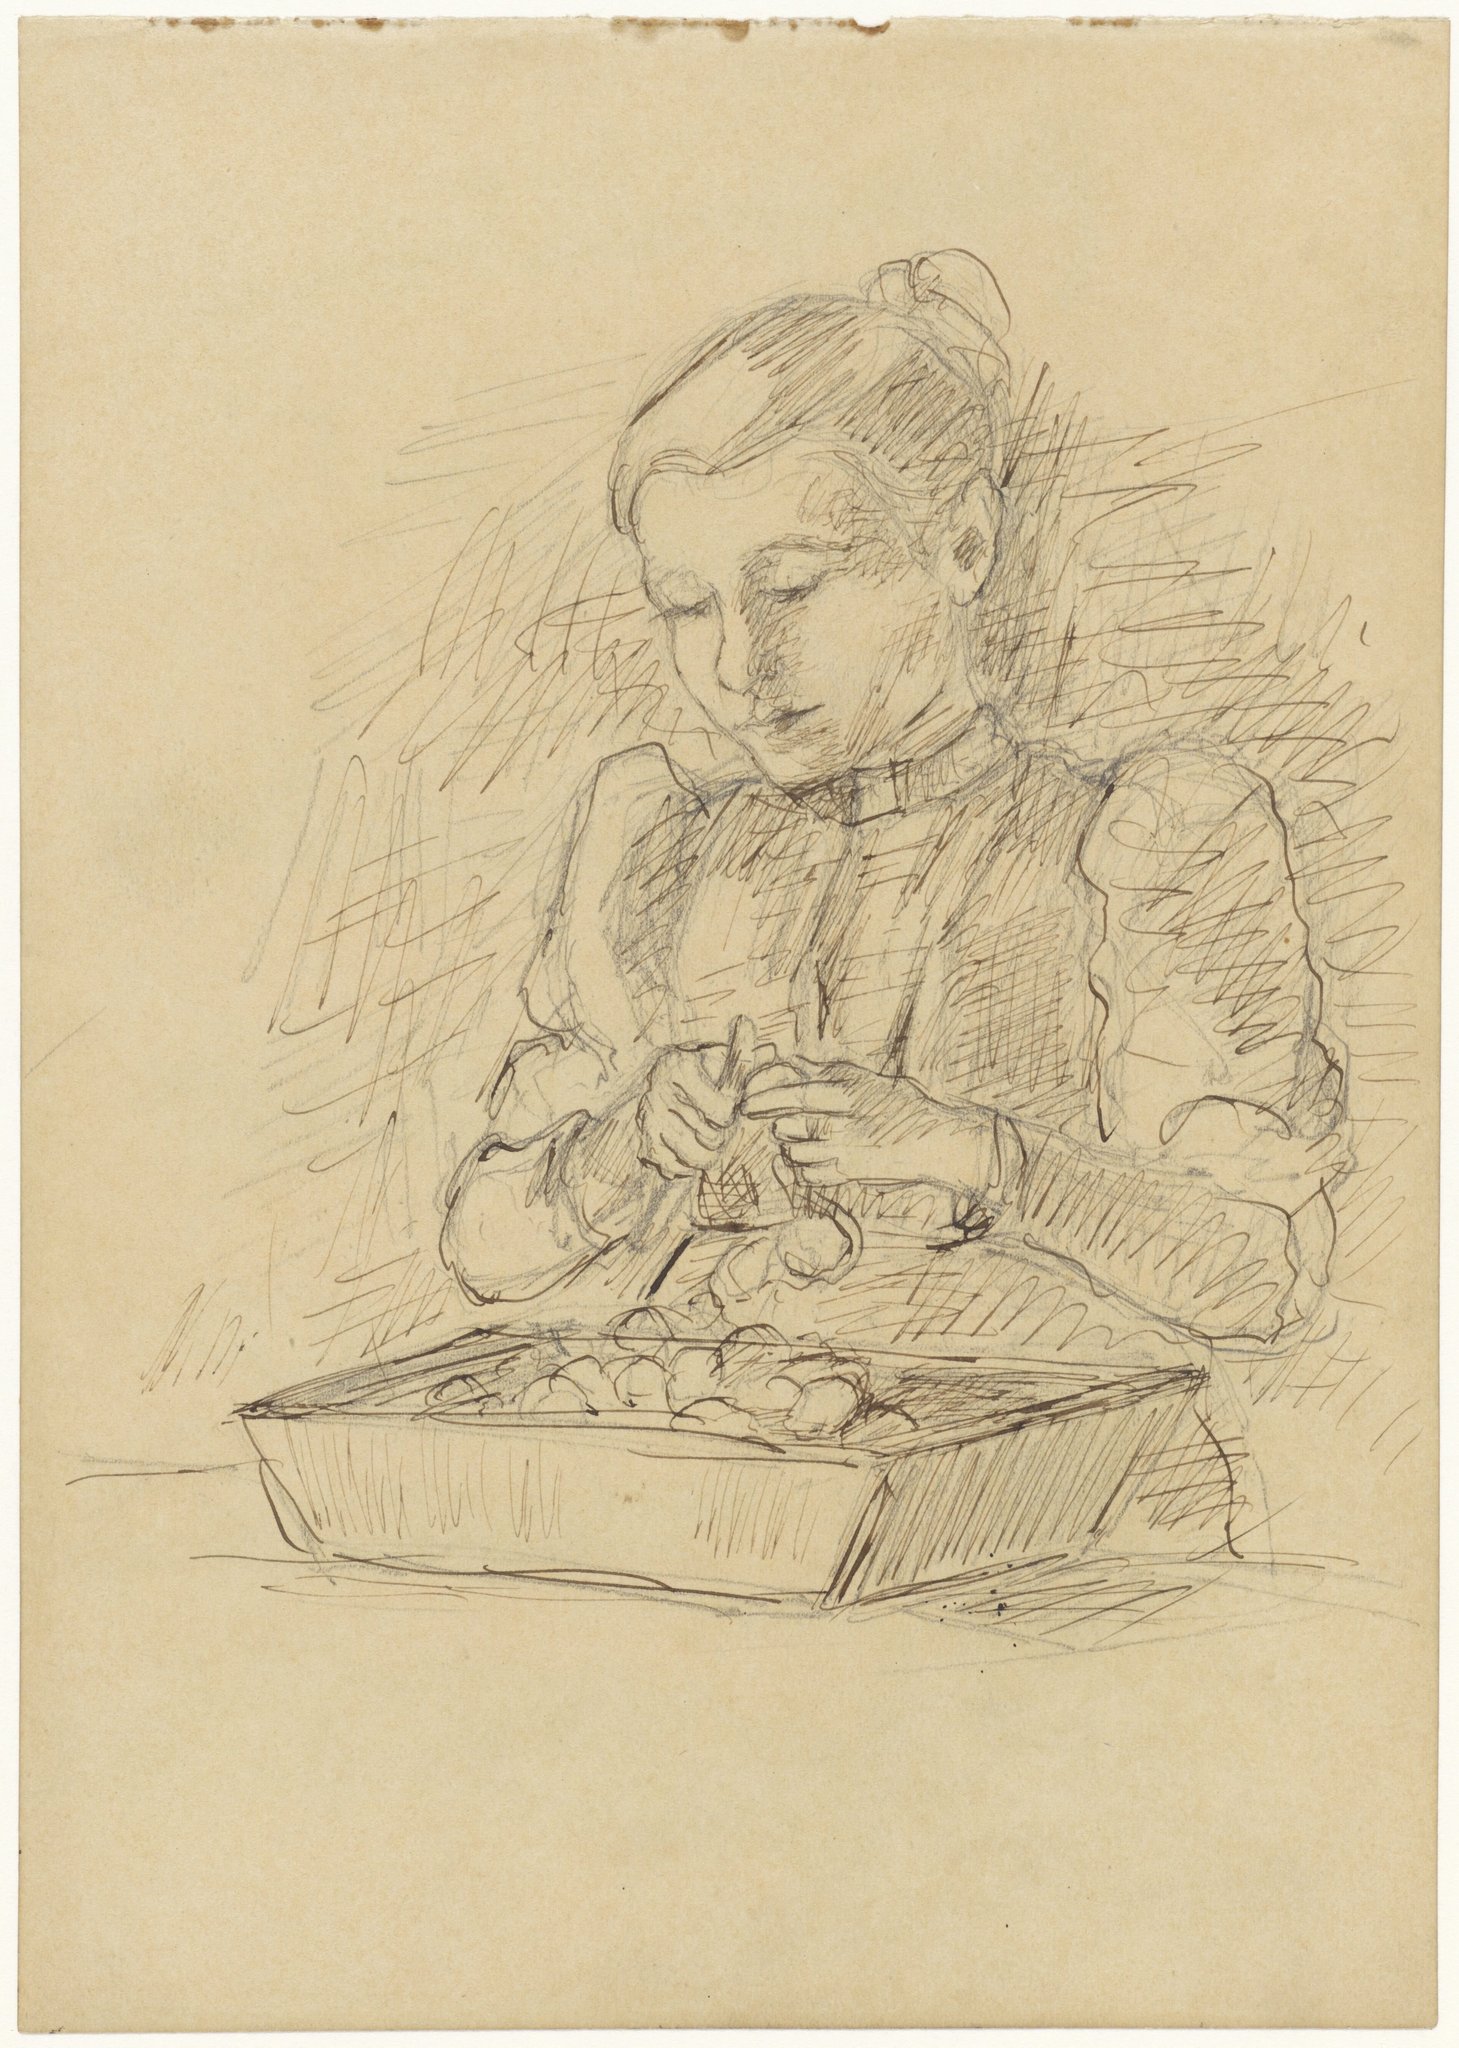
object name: drawing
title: Aardappelen schillende vrouw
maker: jozef israëls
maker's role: draughtsman, painter, print maker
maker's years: 1824-1911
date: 1834-1911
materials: ink, paper, pencil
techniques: pen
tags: potatoes, cleaning vegetables